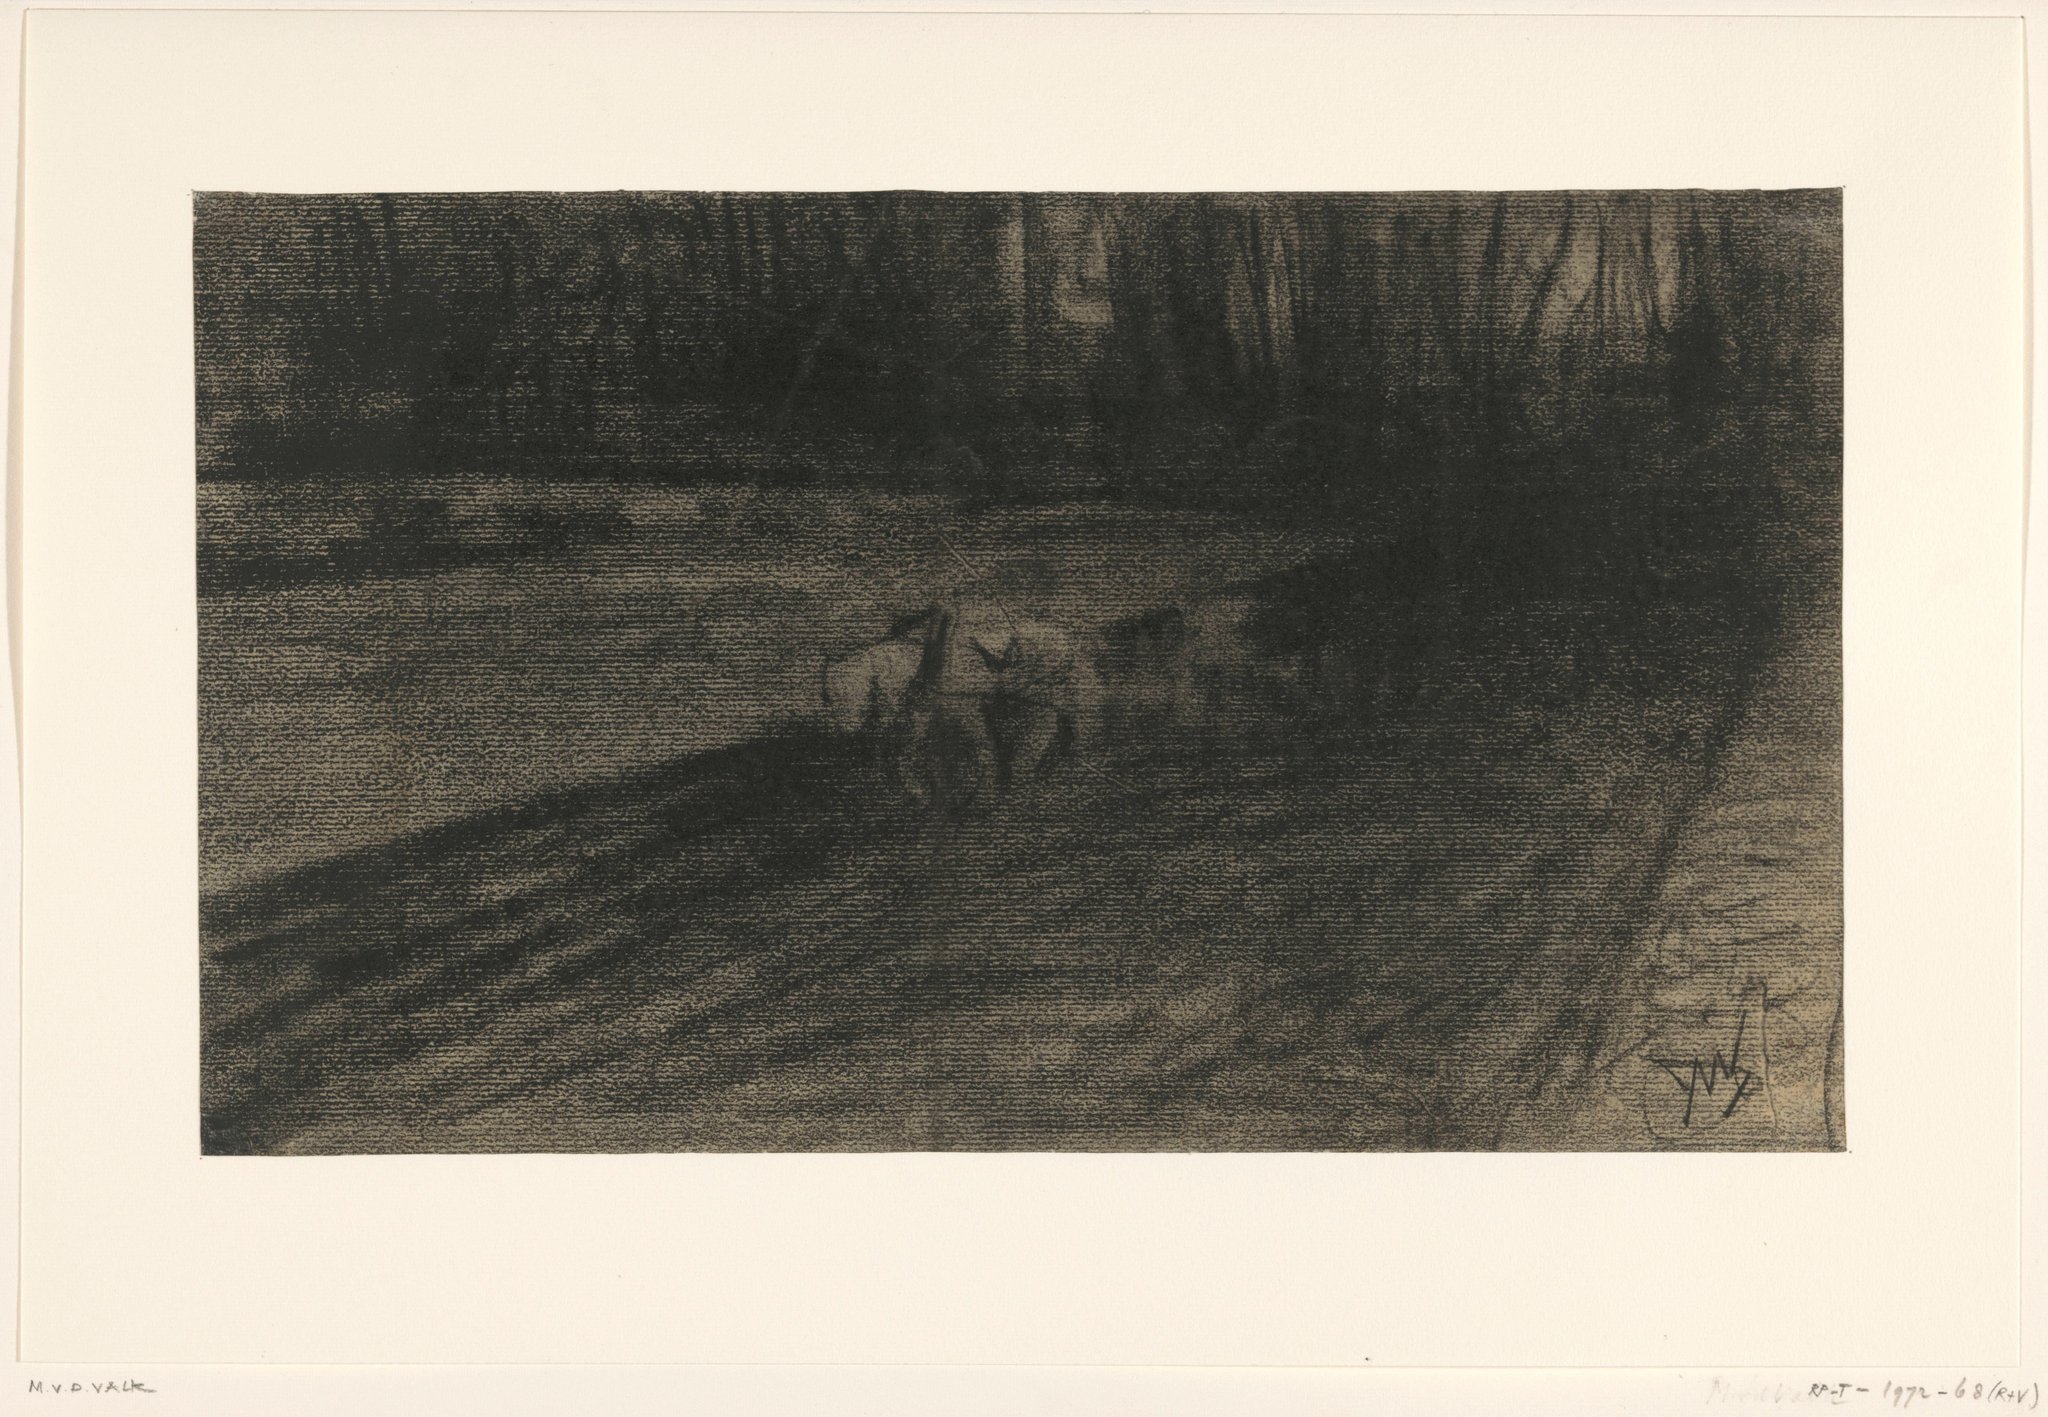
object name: drawing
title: Ploegende paarden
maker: maurits van der valk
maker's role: draughtsman, print maker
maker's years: 1857-1935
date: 1867-1935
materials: charcoal, paper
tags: cultivated land, horse